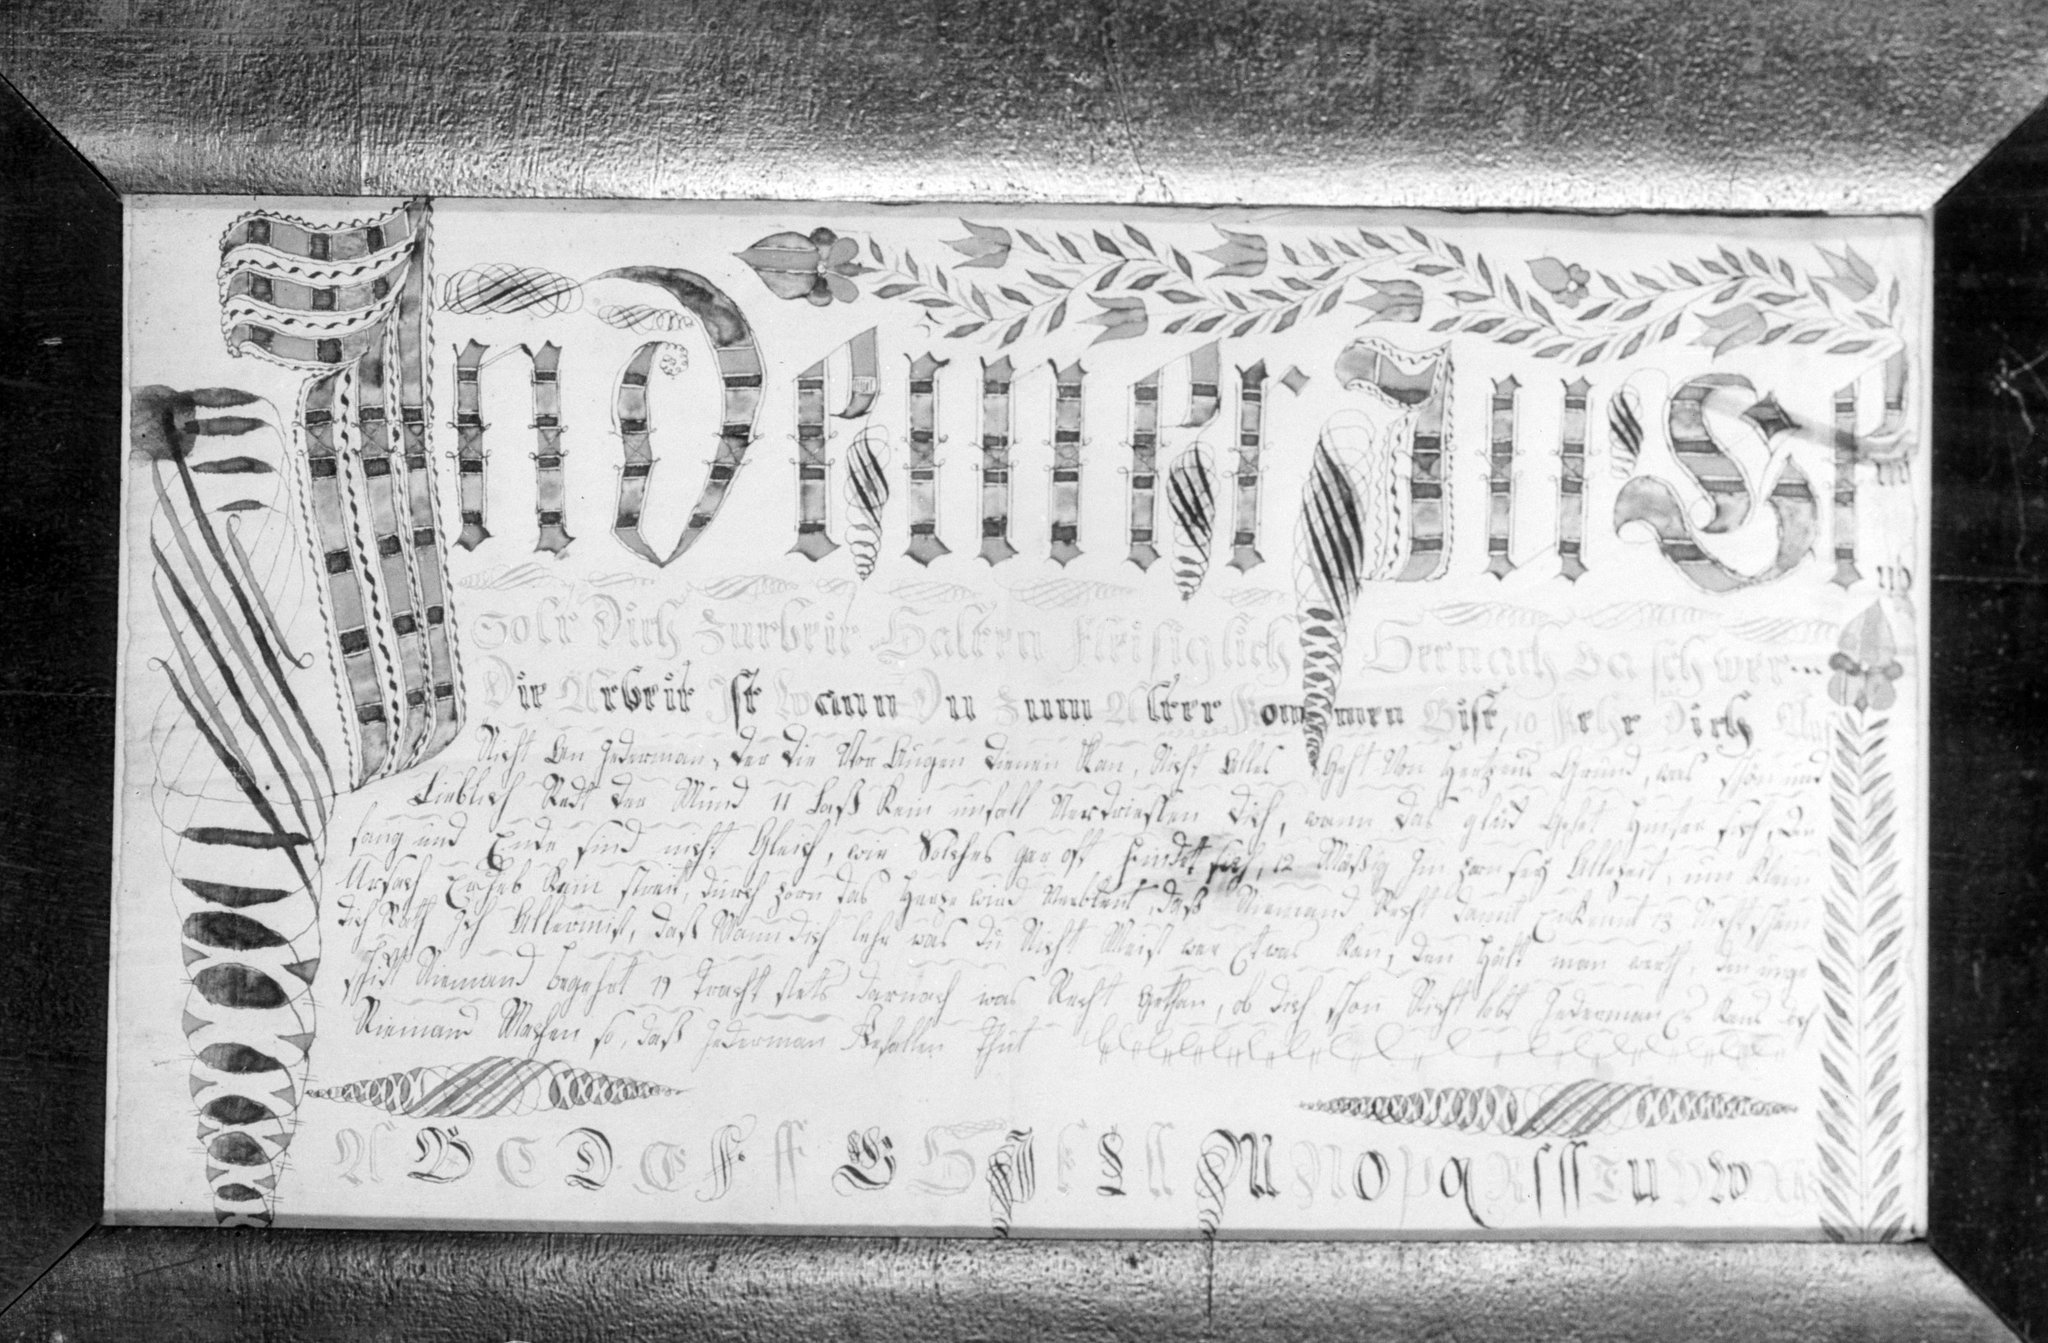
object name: manuscript sampler, fraktur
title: Manuscript Sampler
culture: american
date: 1800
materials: ink, paper, watercolor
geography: united states